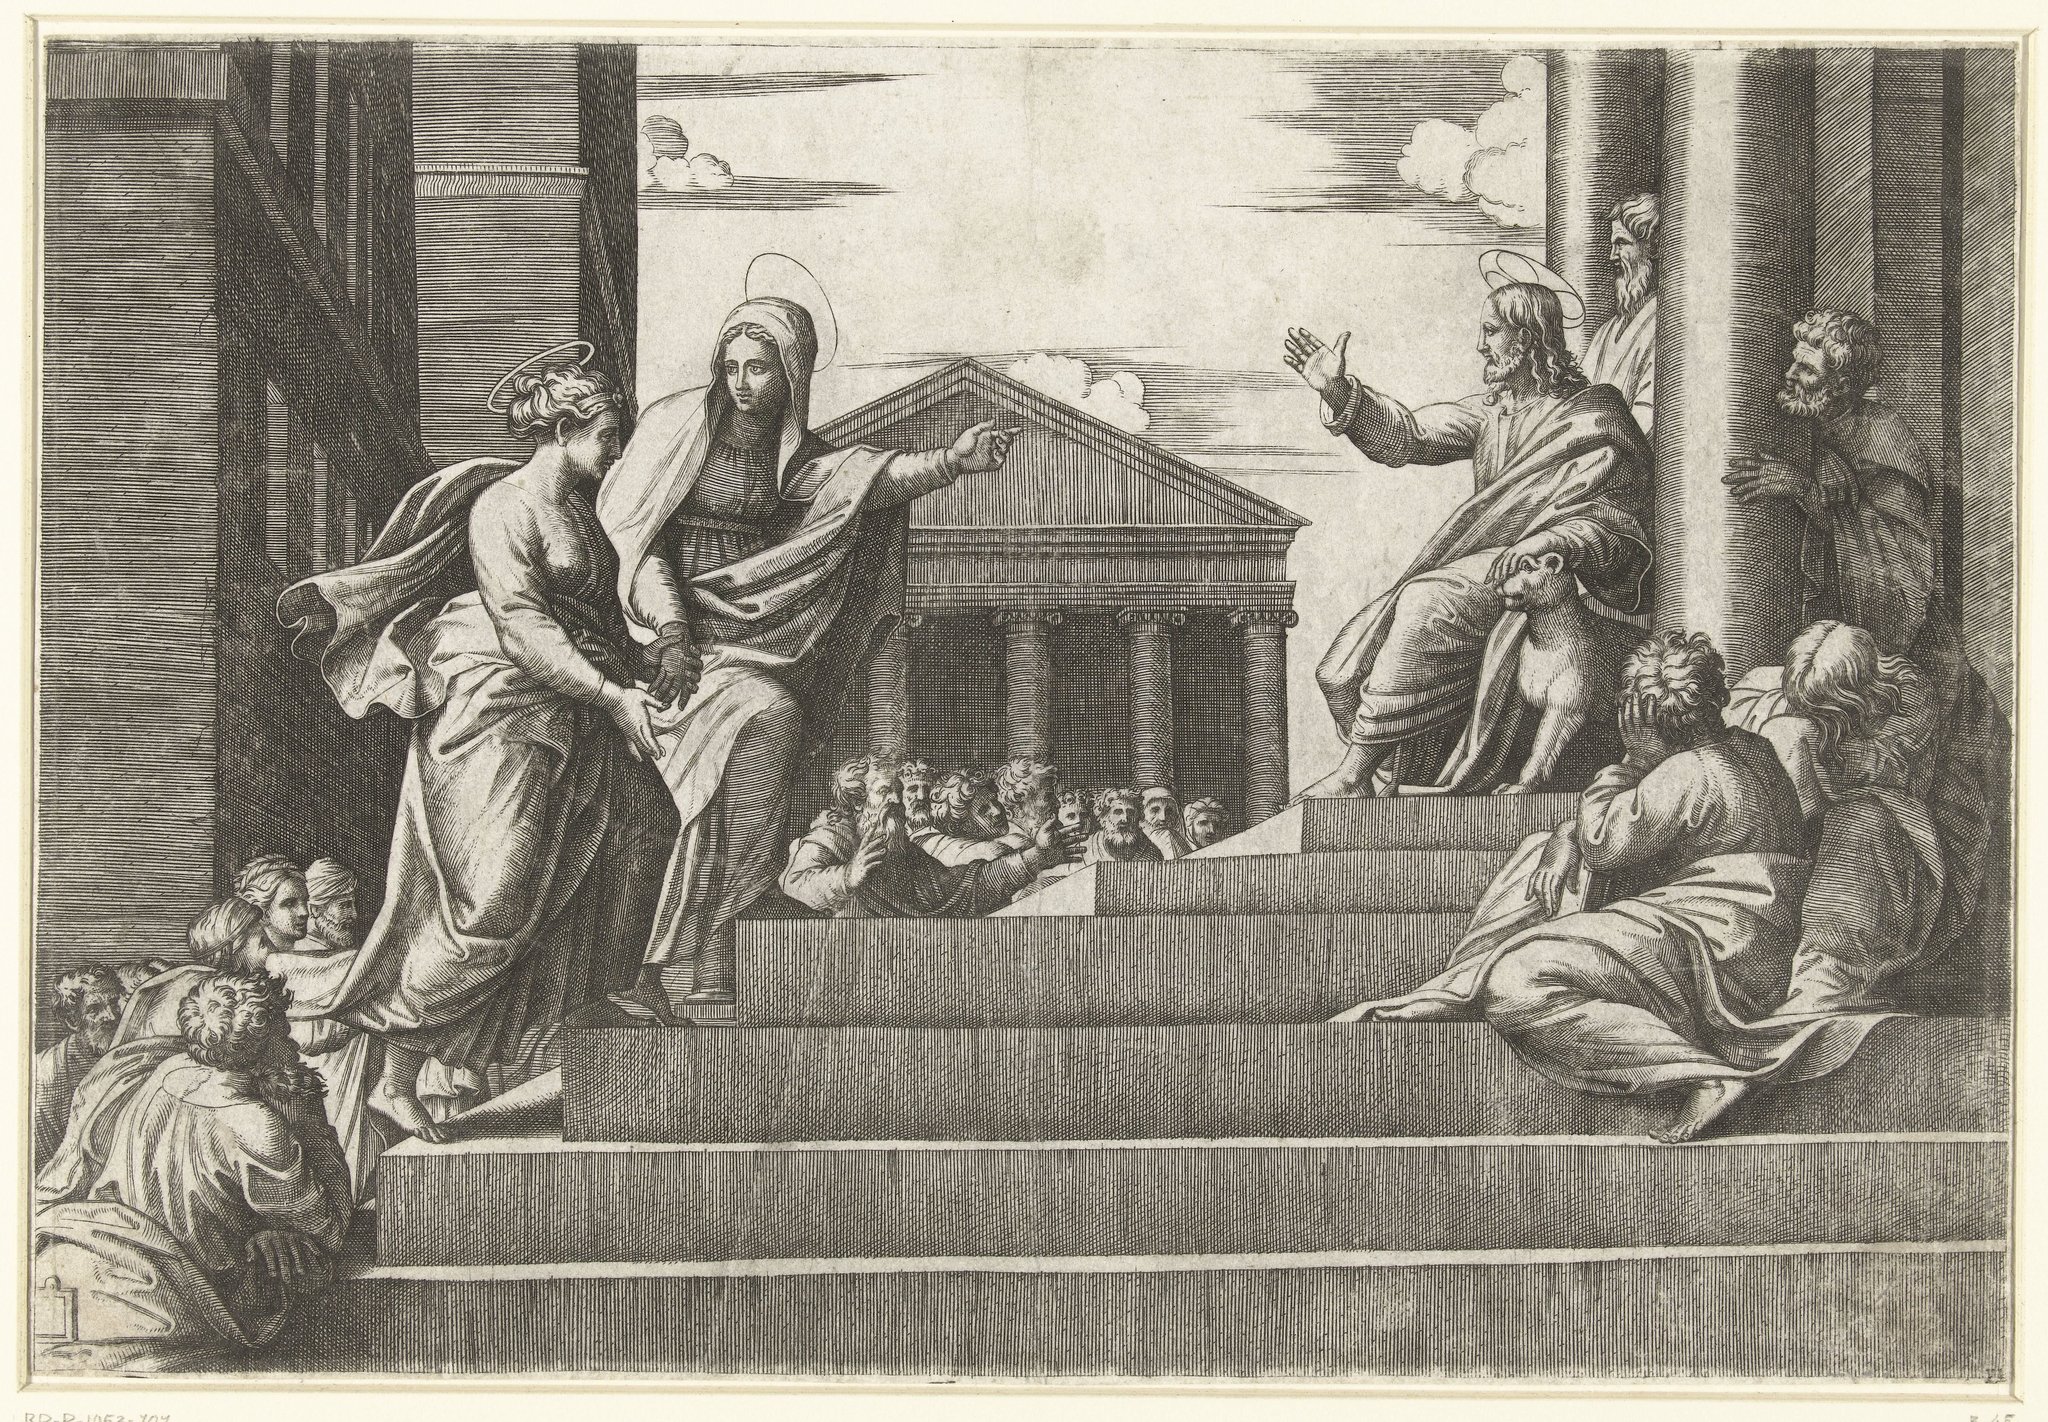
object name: print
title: Marta leidt Maria Magdalena naar Christus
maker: marcantonio raimondi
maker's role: print maker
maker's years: 1470-1534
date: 1520-1525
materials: paper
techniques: engraving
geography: italy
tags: martha meets christ at the gate of bethany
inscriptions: collector's mark: Lugt 2760, collector's mark: Lugt 2228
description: Prent naar ontwerp van Giulio Romano voor een niet bewaard gebleven fresco in de S. Trinità dei Monti, Rome.